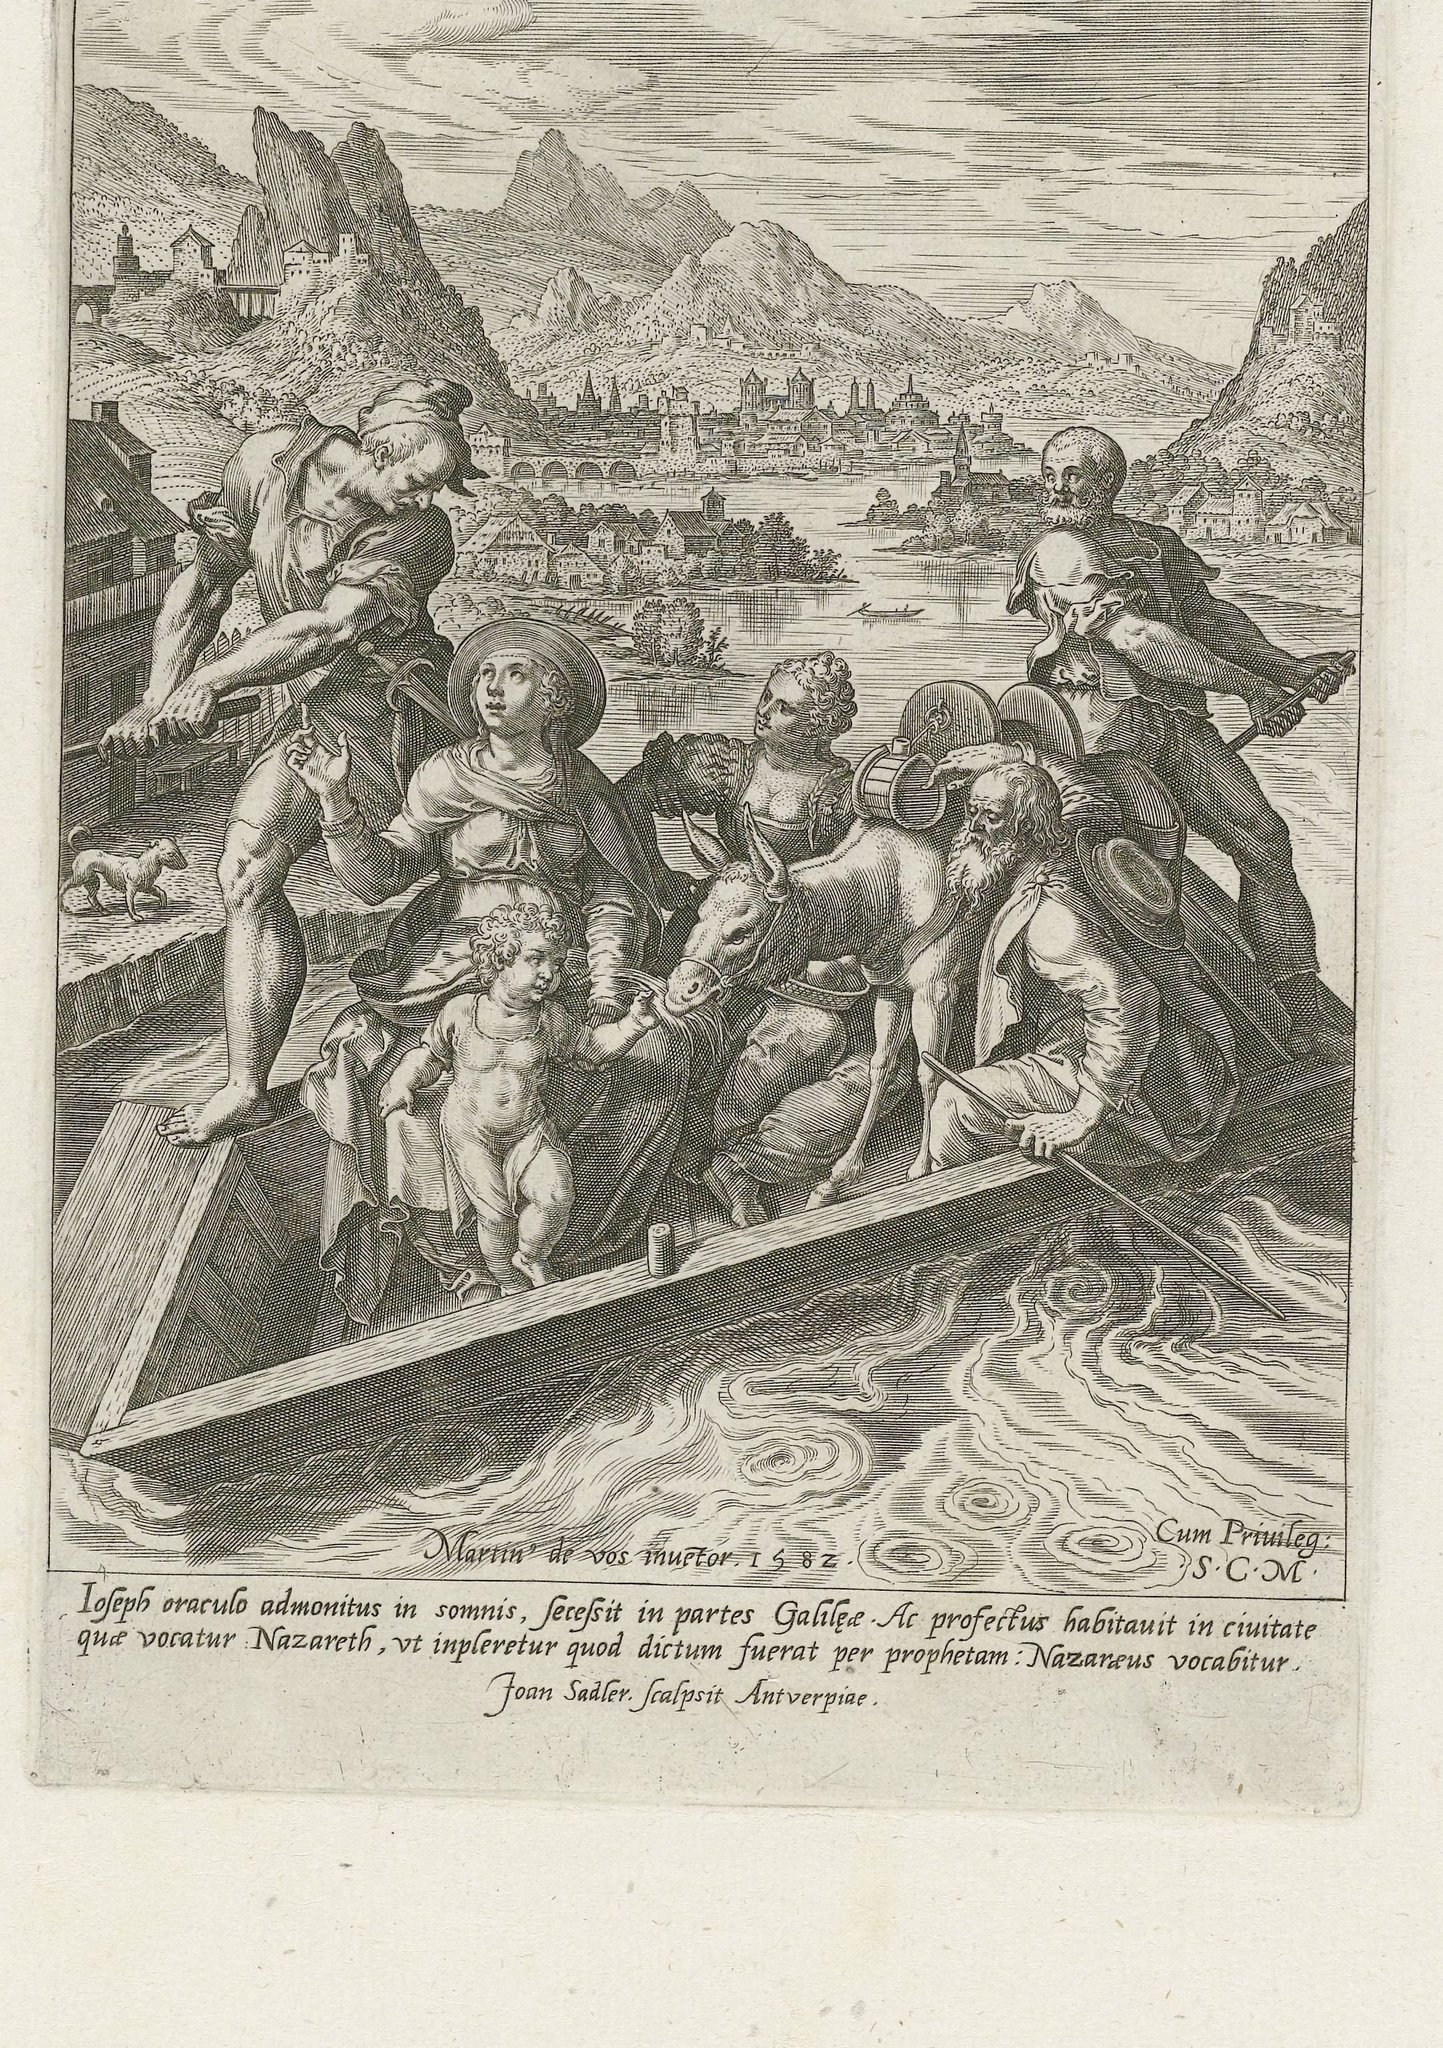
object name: print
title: Geboorte en eerste jaren van Christus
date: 1582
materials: paper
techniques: engraving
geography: antwerp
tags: the holy family (and sometimes others) returning to israel, crossing a river in a boat, perhaps an angel (or sometimes charon) as ferryman ~ the flight into egypt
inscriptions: collector's mark: Lugt 2760, collector's mark: Lugt 2228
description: Maria, Jozef en het Christuskind keren per boot terug naar Israël. Het Christuskind voedt de ezel wat stro. De prent heeft een Latijns Bijbelcitaat als onderschrift en is de elfde prent van een twaalfdelige serie over de geboorte en de eerste jaren van Christus.